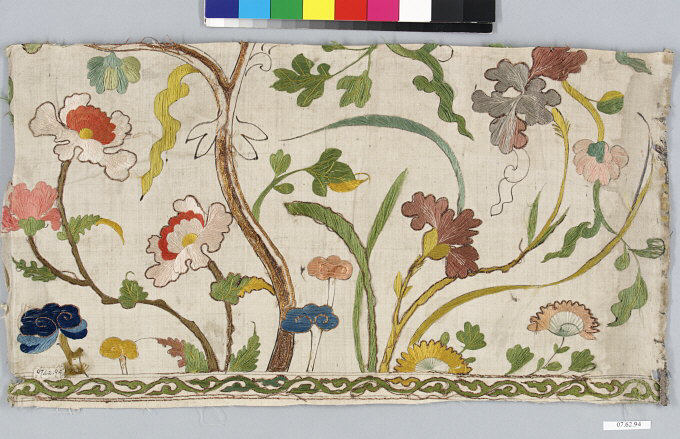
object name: fragment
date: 1701-1800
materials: silk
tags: flowers,leaves